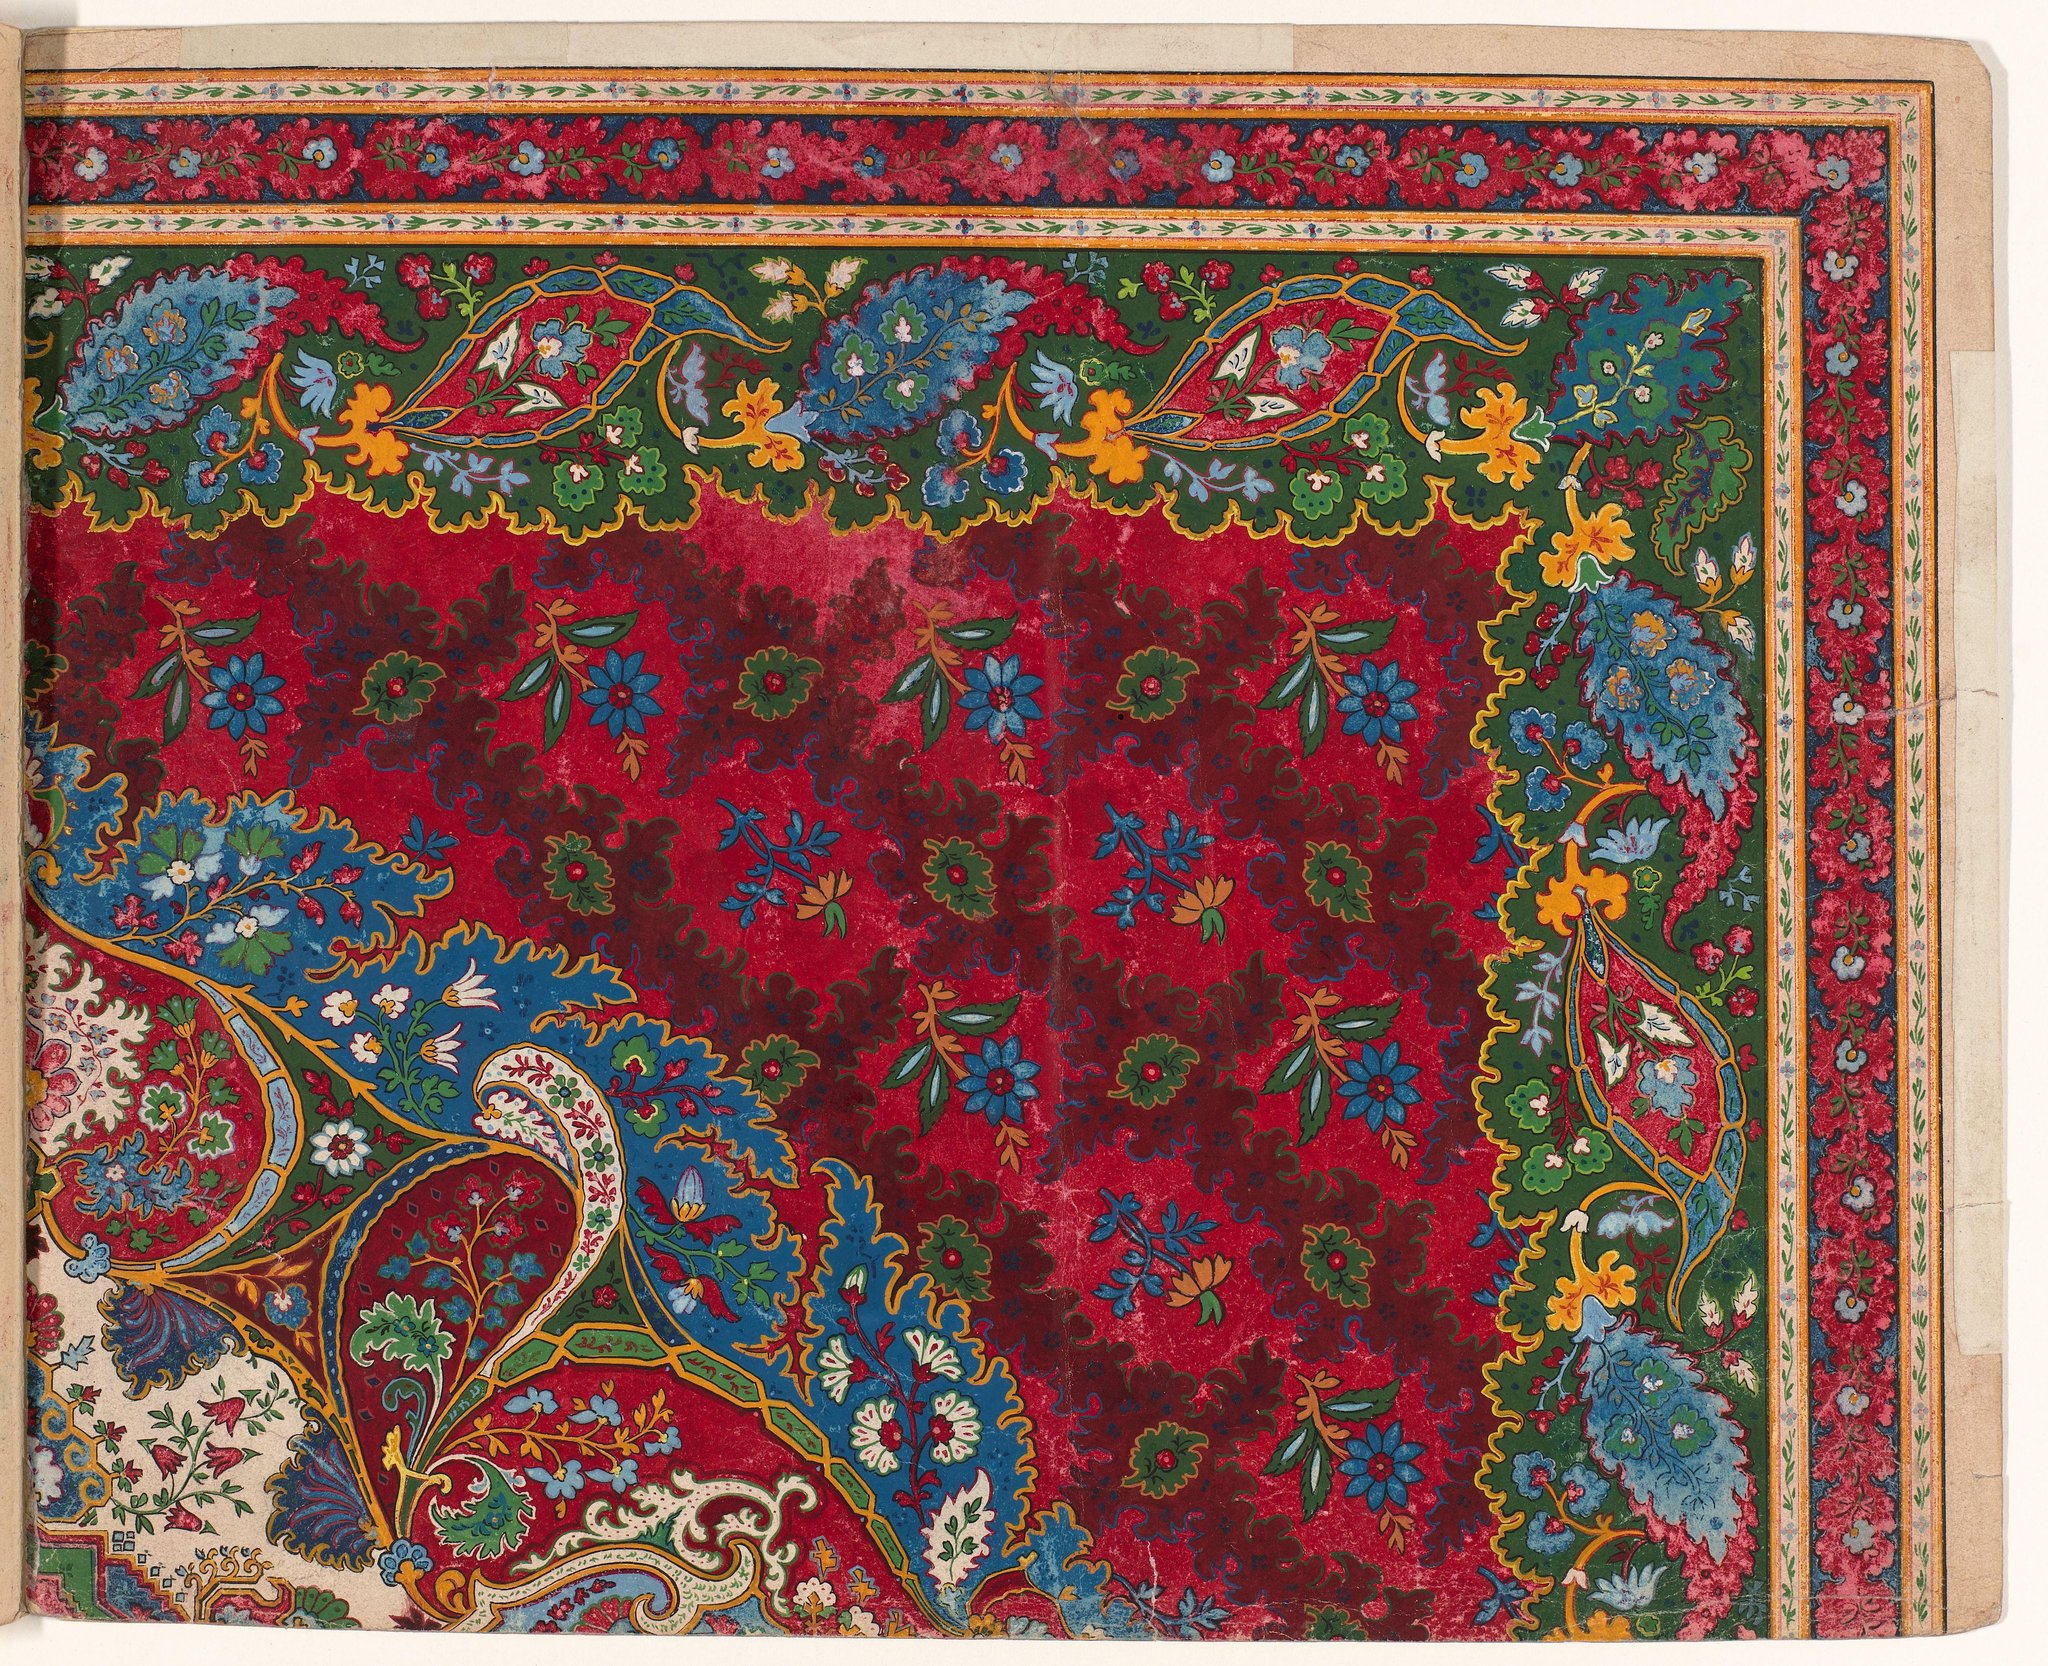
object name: drawing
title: Ontwerp voor een tapijt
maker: Anonymous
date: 1854-1864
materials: gouache, paper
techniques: brush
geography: deventer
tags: ornaments ~ art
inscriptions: retailer's mark: ‘JHS.’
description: De presentatietekeningen BK-1971-77-1 t/m 86 zijn kopieën van de originele ontwerptekeningen. Ze werden gemaakt voor vertegenwoordigers van bijvoorbeeld magazijnen, die ze aan hun klanten konden tonen. De meeste tekeningen tonen een kwart van het dessin inclusief rand, middenpartij (de zogenaamde grond of fond) en centraal medaillon. Door het gebruik van spiegels kan de illusie van het gehele tapijt worden opgeroepen. Een deel van de tekeningen heeft een alfabetische opeenvolgende letter als kenmerk, de andere groep een cijfer.Waarschijnlijk is de reeks dessins met een letter eerder samengesteld dan de genummerde tekeningen.